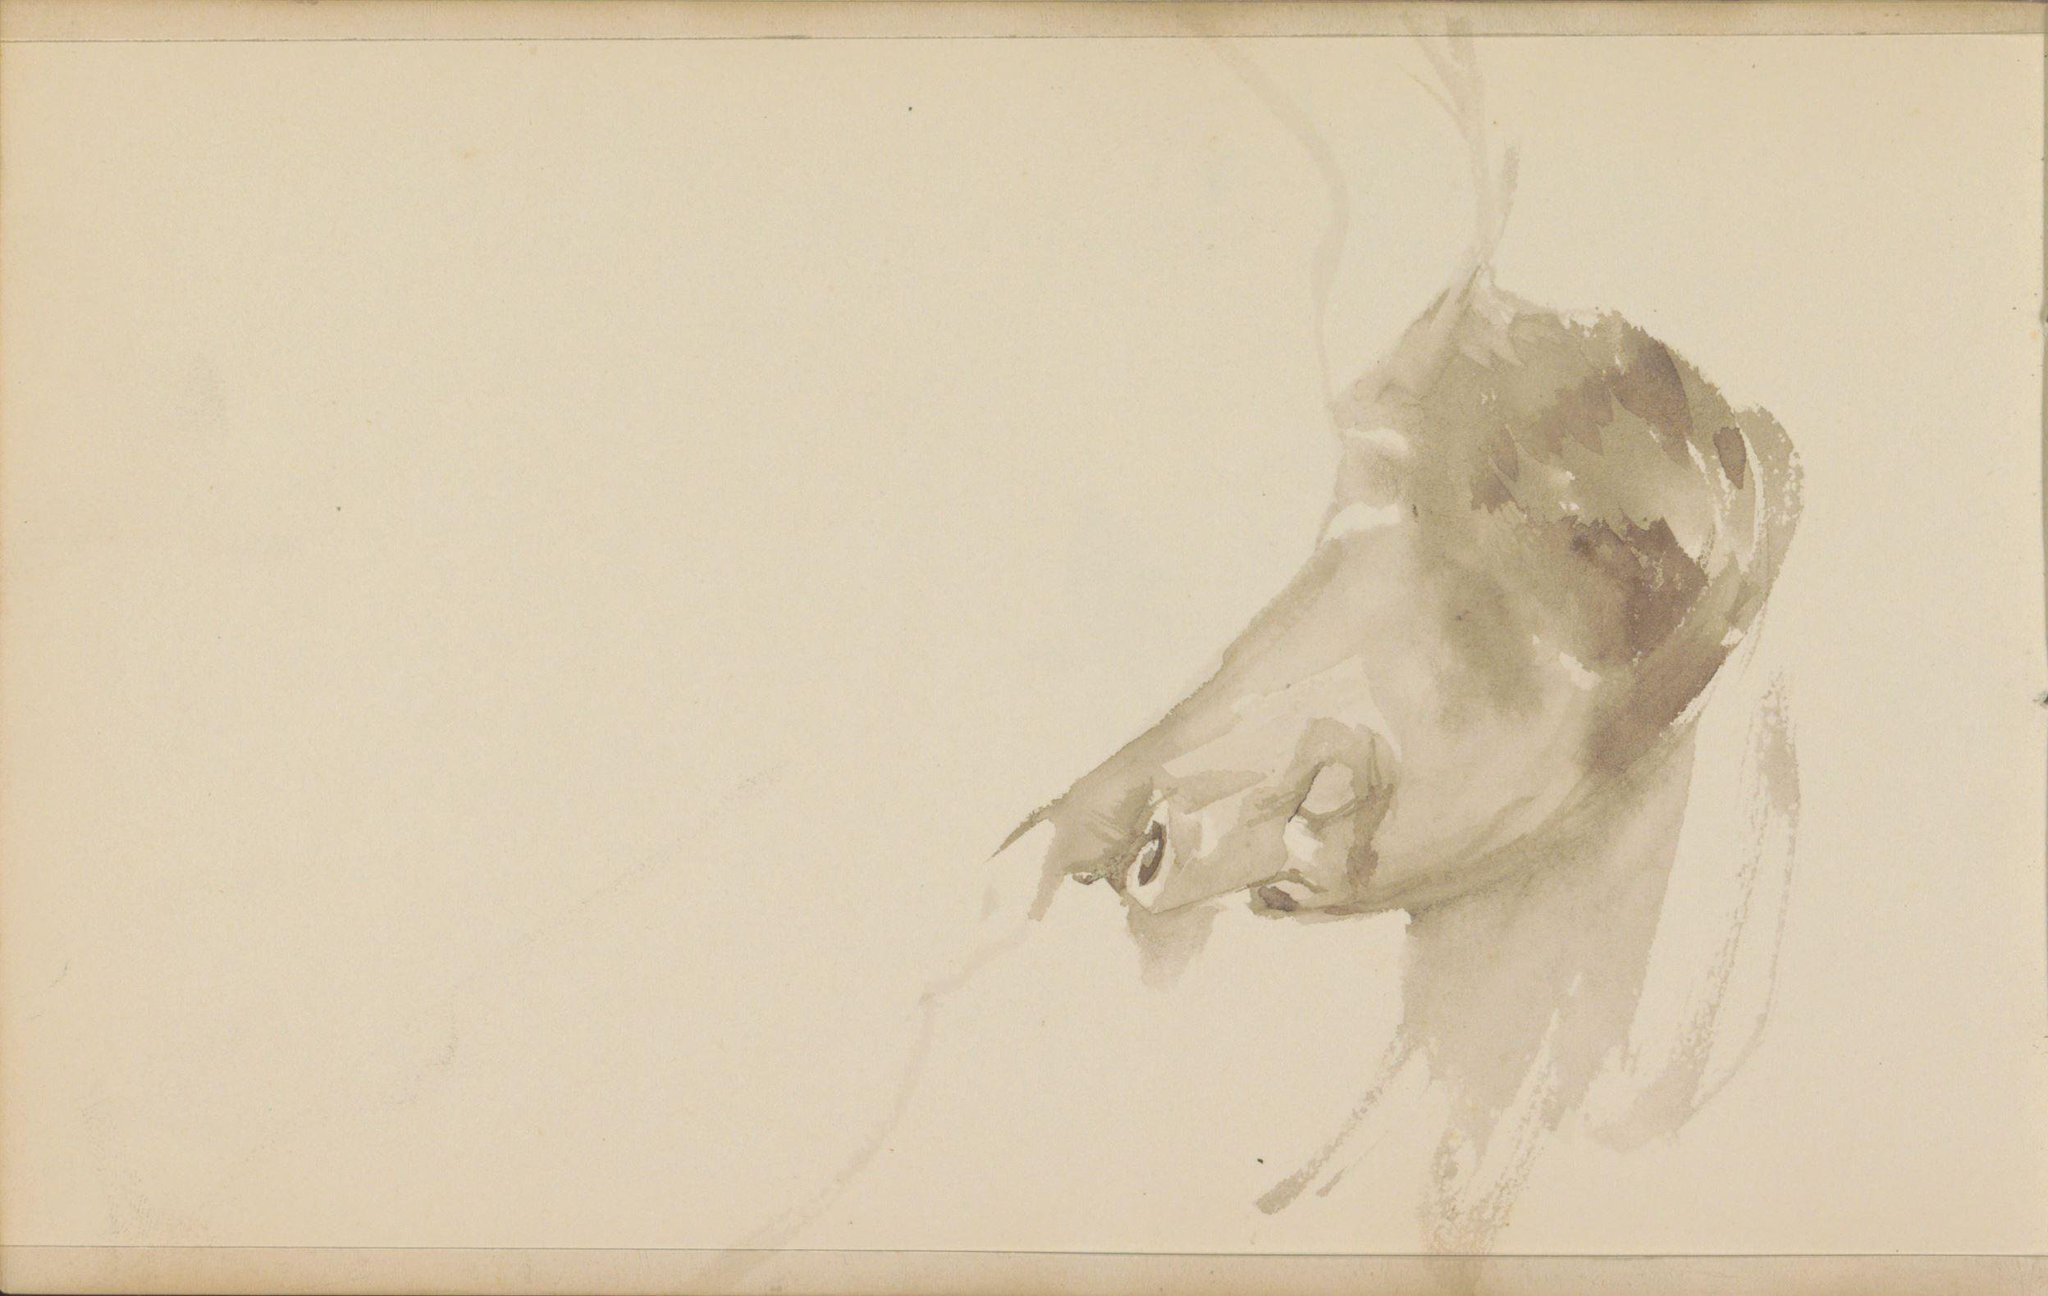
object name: sketchbook leaf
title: Portretkop van een slapende Alphons Grandmont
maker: a.a.l. de grammont-hubrecht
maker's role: draughtsman, painter, print maker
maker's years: 1855-1913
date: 1892-1913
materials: ink, paper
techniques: brush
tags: head (human), adult man, eyes closed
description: Blad 12 verso uit een schetsboek met 31 bladen.